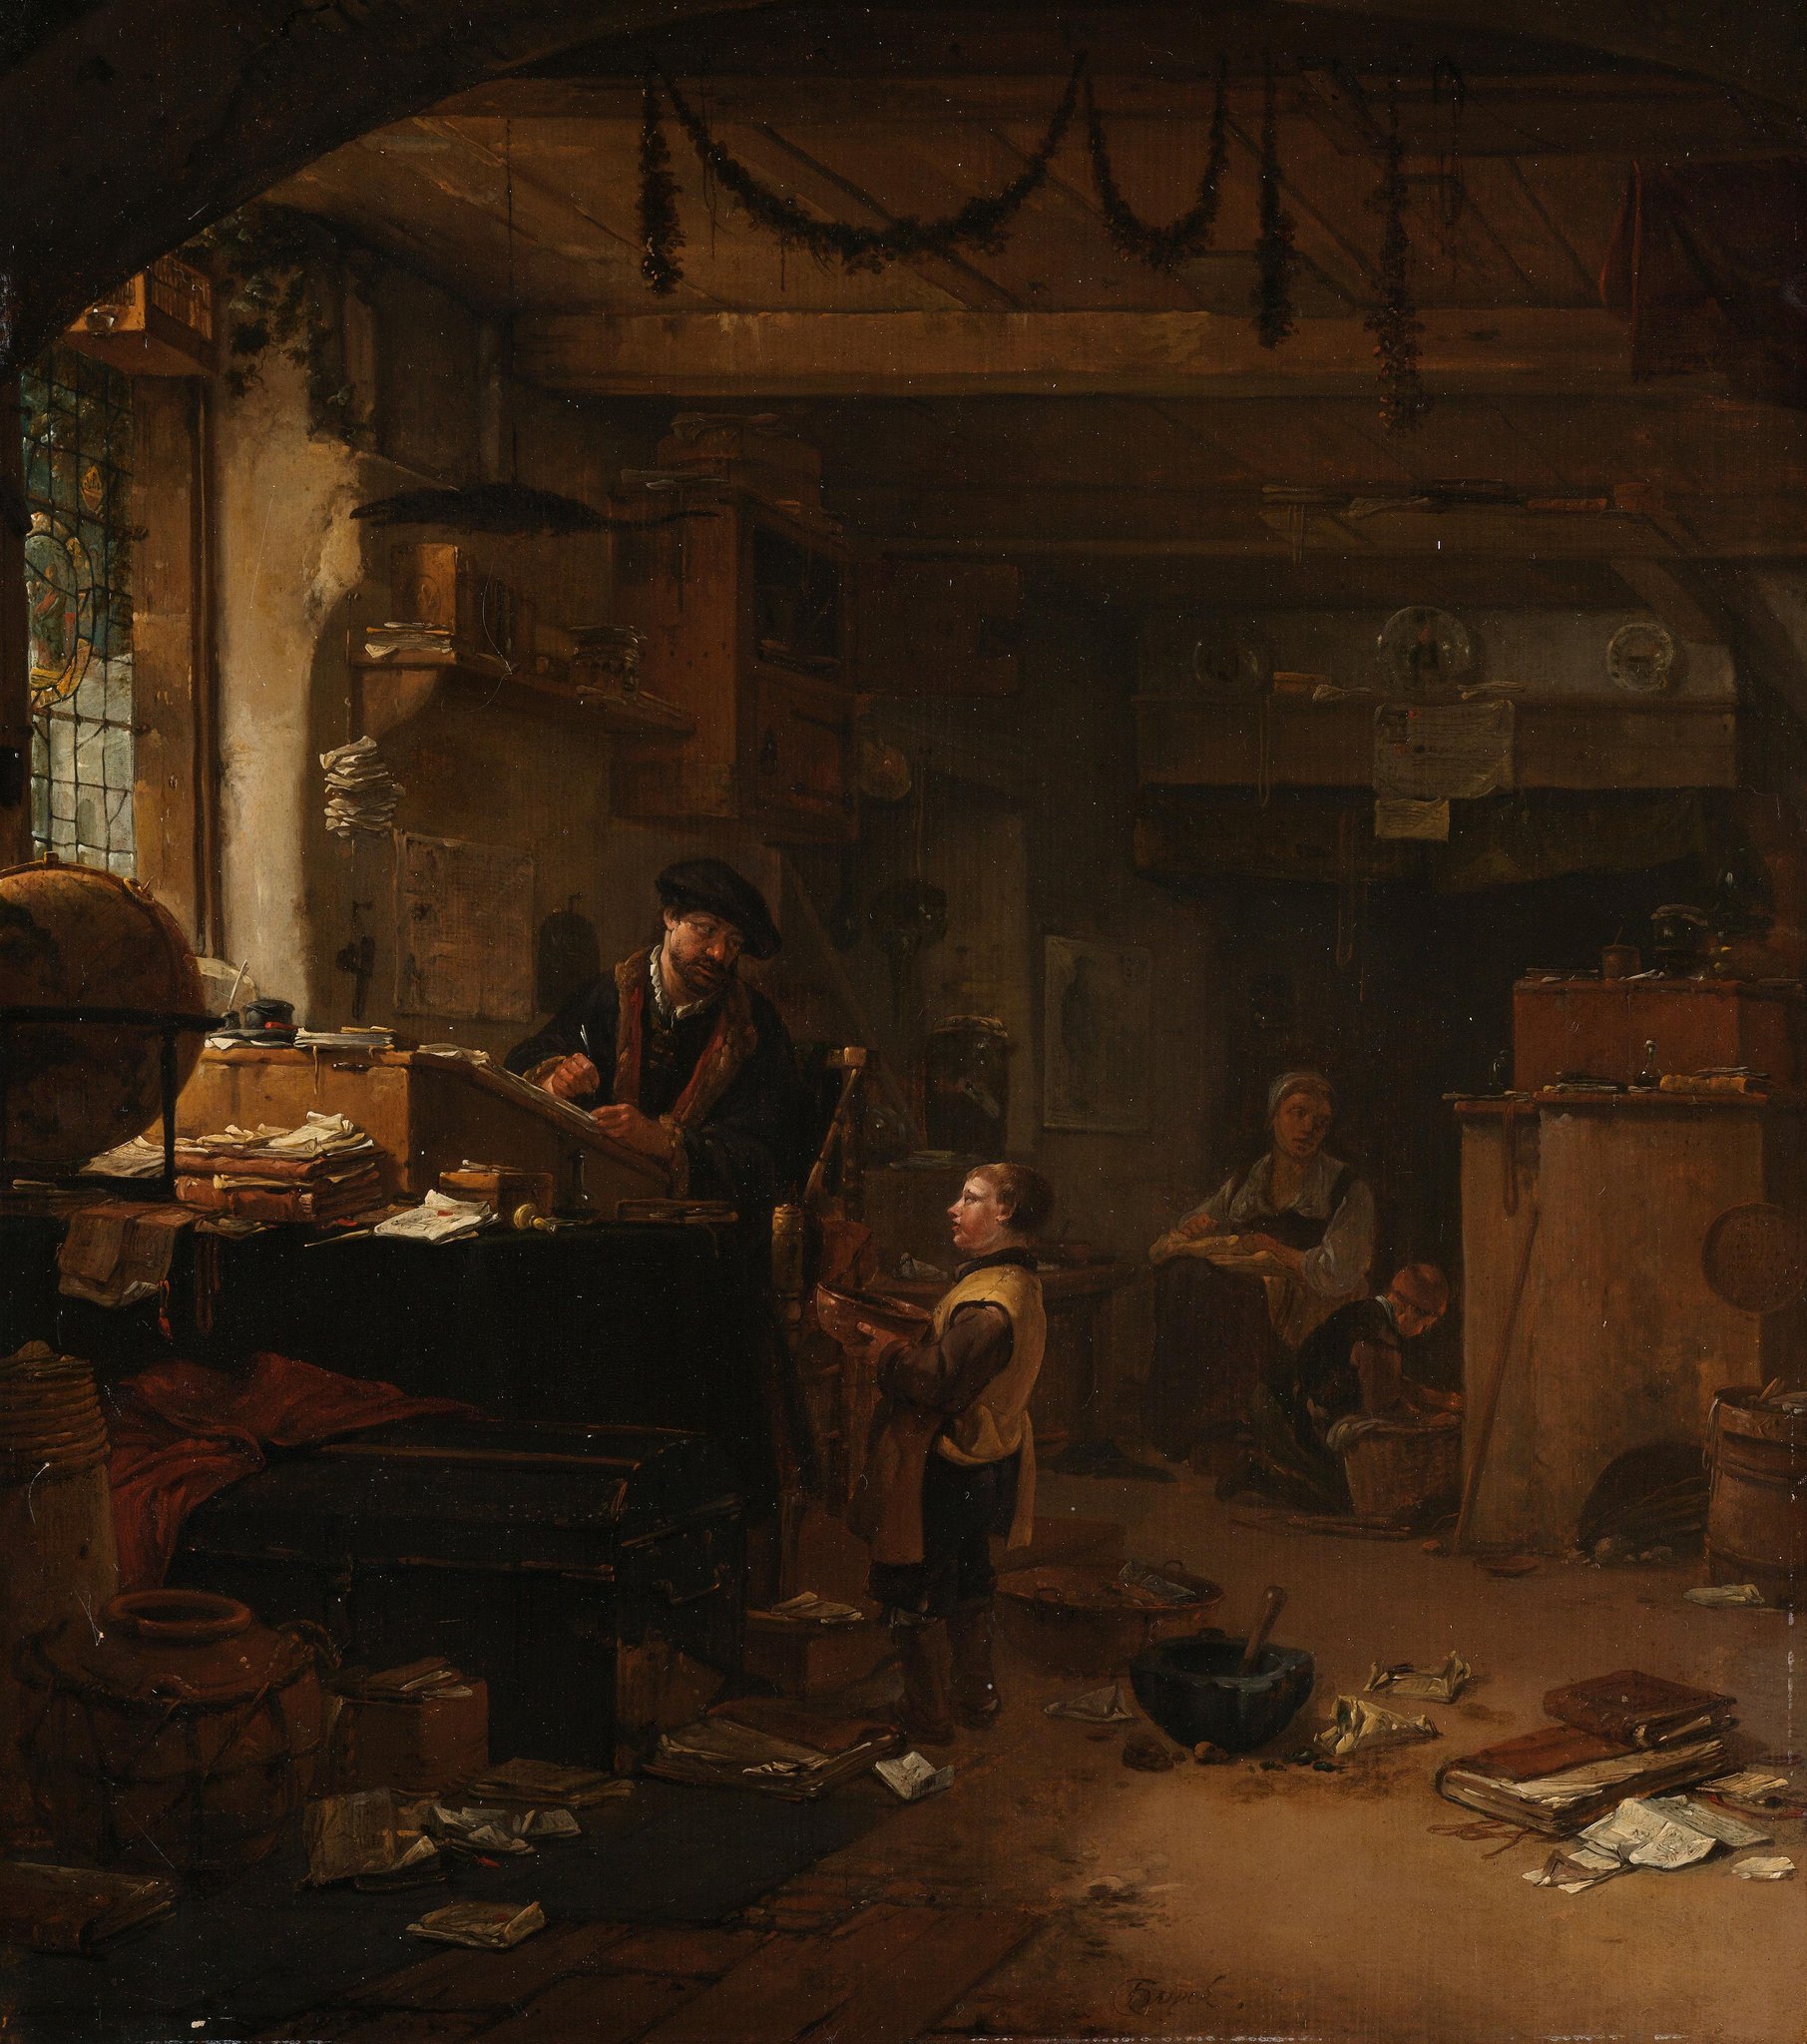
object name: painting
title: The Alchemist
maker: thomas wijck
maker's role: draughtsman, painter, print maker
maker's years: 1616-1677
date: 1660-1670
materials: oil, panel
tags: alchemist at work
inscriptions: signature, bottom centre (T and w ligated): ‘Twyck’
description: Een alchemist zittend schrijvend aan een lessenaar in zijn werkplaats. Voor hem staat een jongen met een grote kom. Op de werktafel en op de grond staan stapels boeken en paperassen, potten, ketels, een vijzel en een globe. Van het plafond hangt een opgezette krokodil. Op de achtergrond zit een vrouw met een kind naast een fornuis.